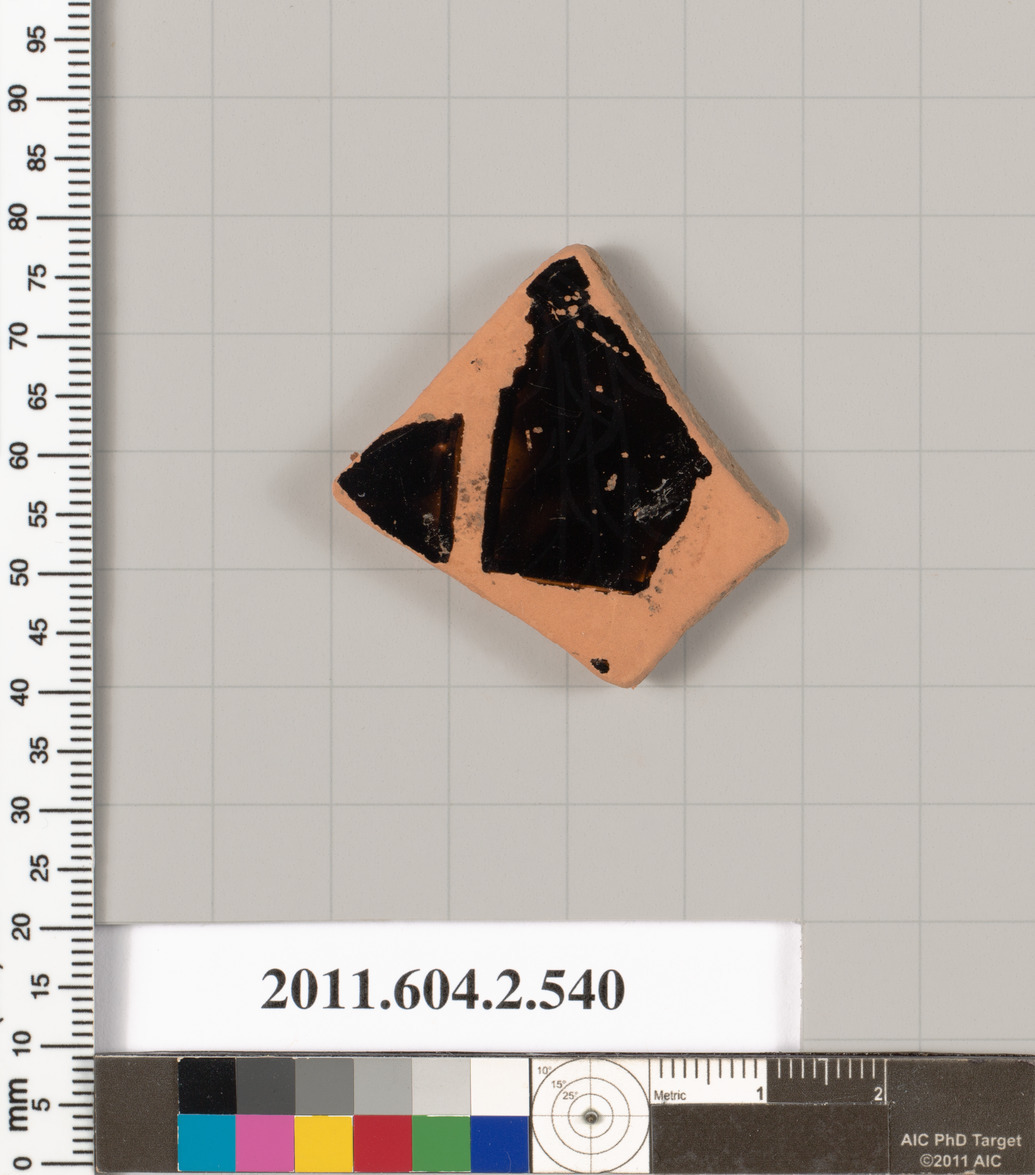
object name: column krater fragment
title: Terracotta fragment of a column-krater (bowl for mixing wine and water)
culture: greek, attic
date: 460-440 BCE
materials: terracotta